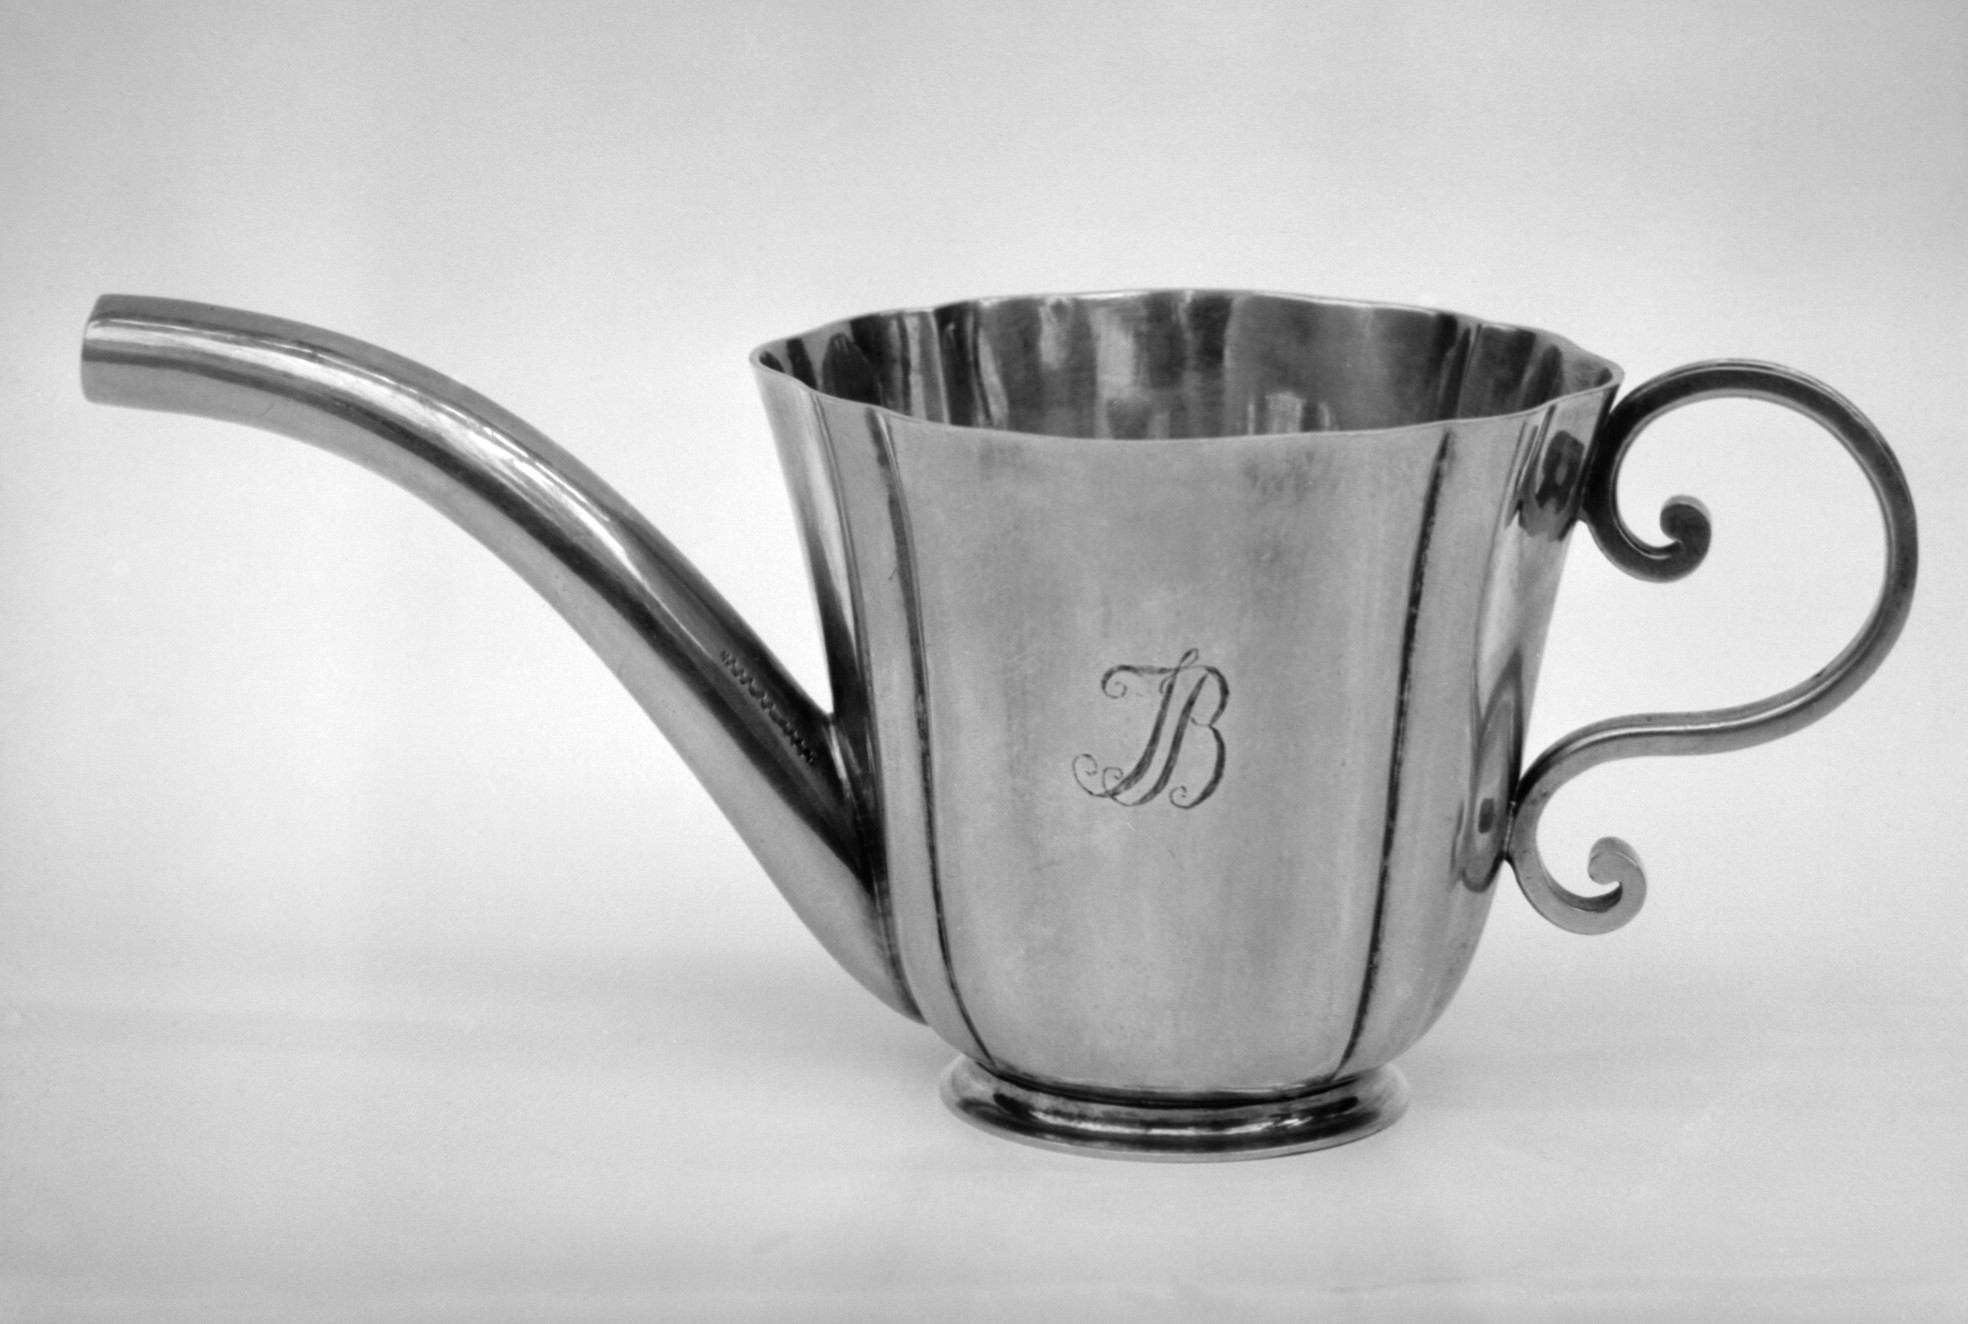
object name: invalid's cup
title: Invalid's cup (Biberon)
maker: luigi valadier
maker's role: artist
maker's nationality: italian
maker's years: 1726-1785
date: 1770-1780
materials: silver gilt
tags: insignia